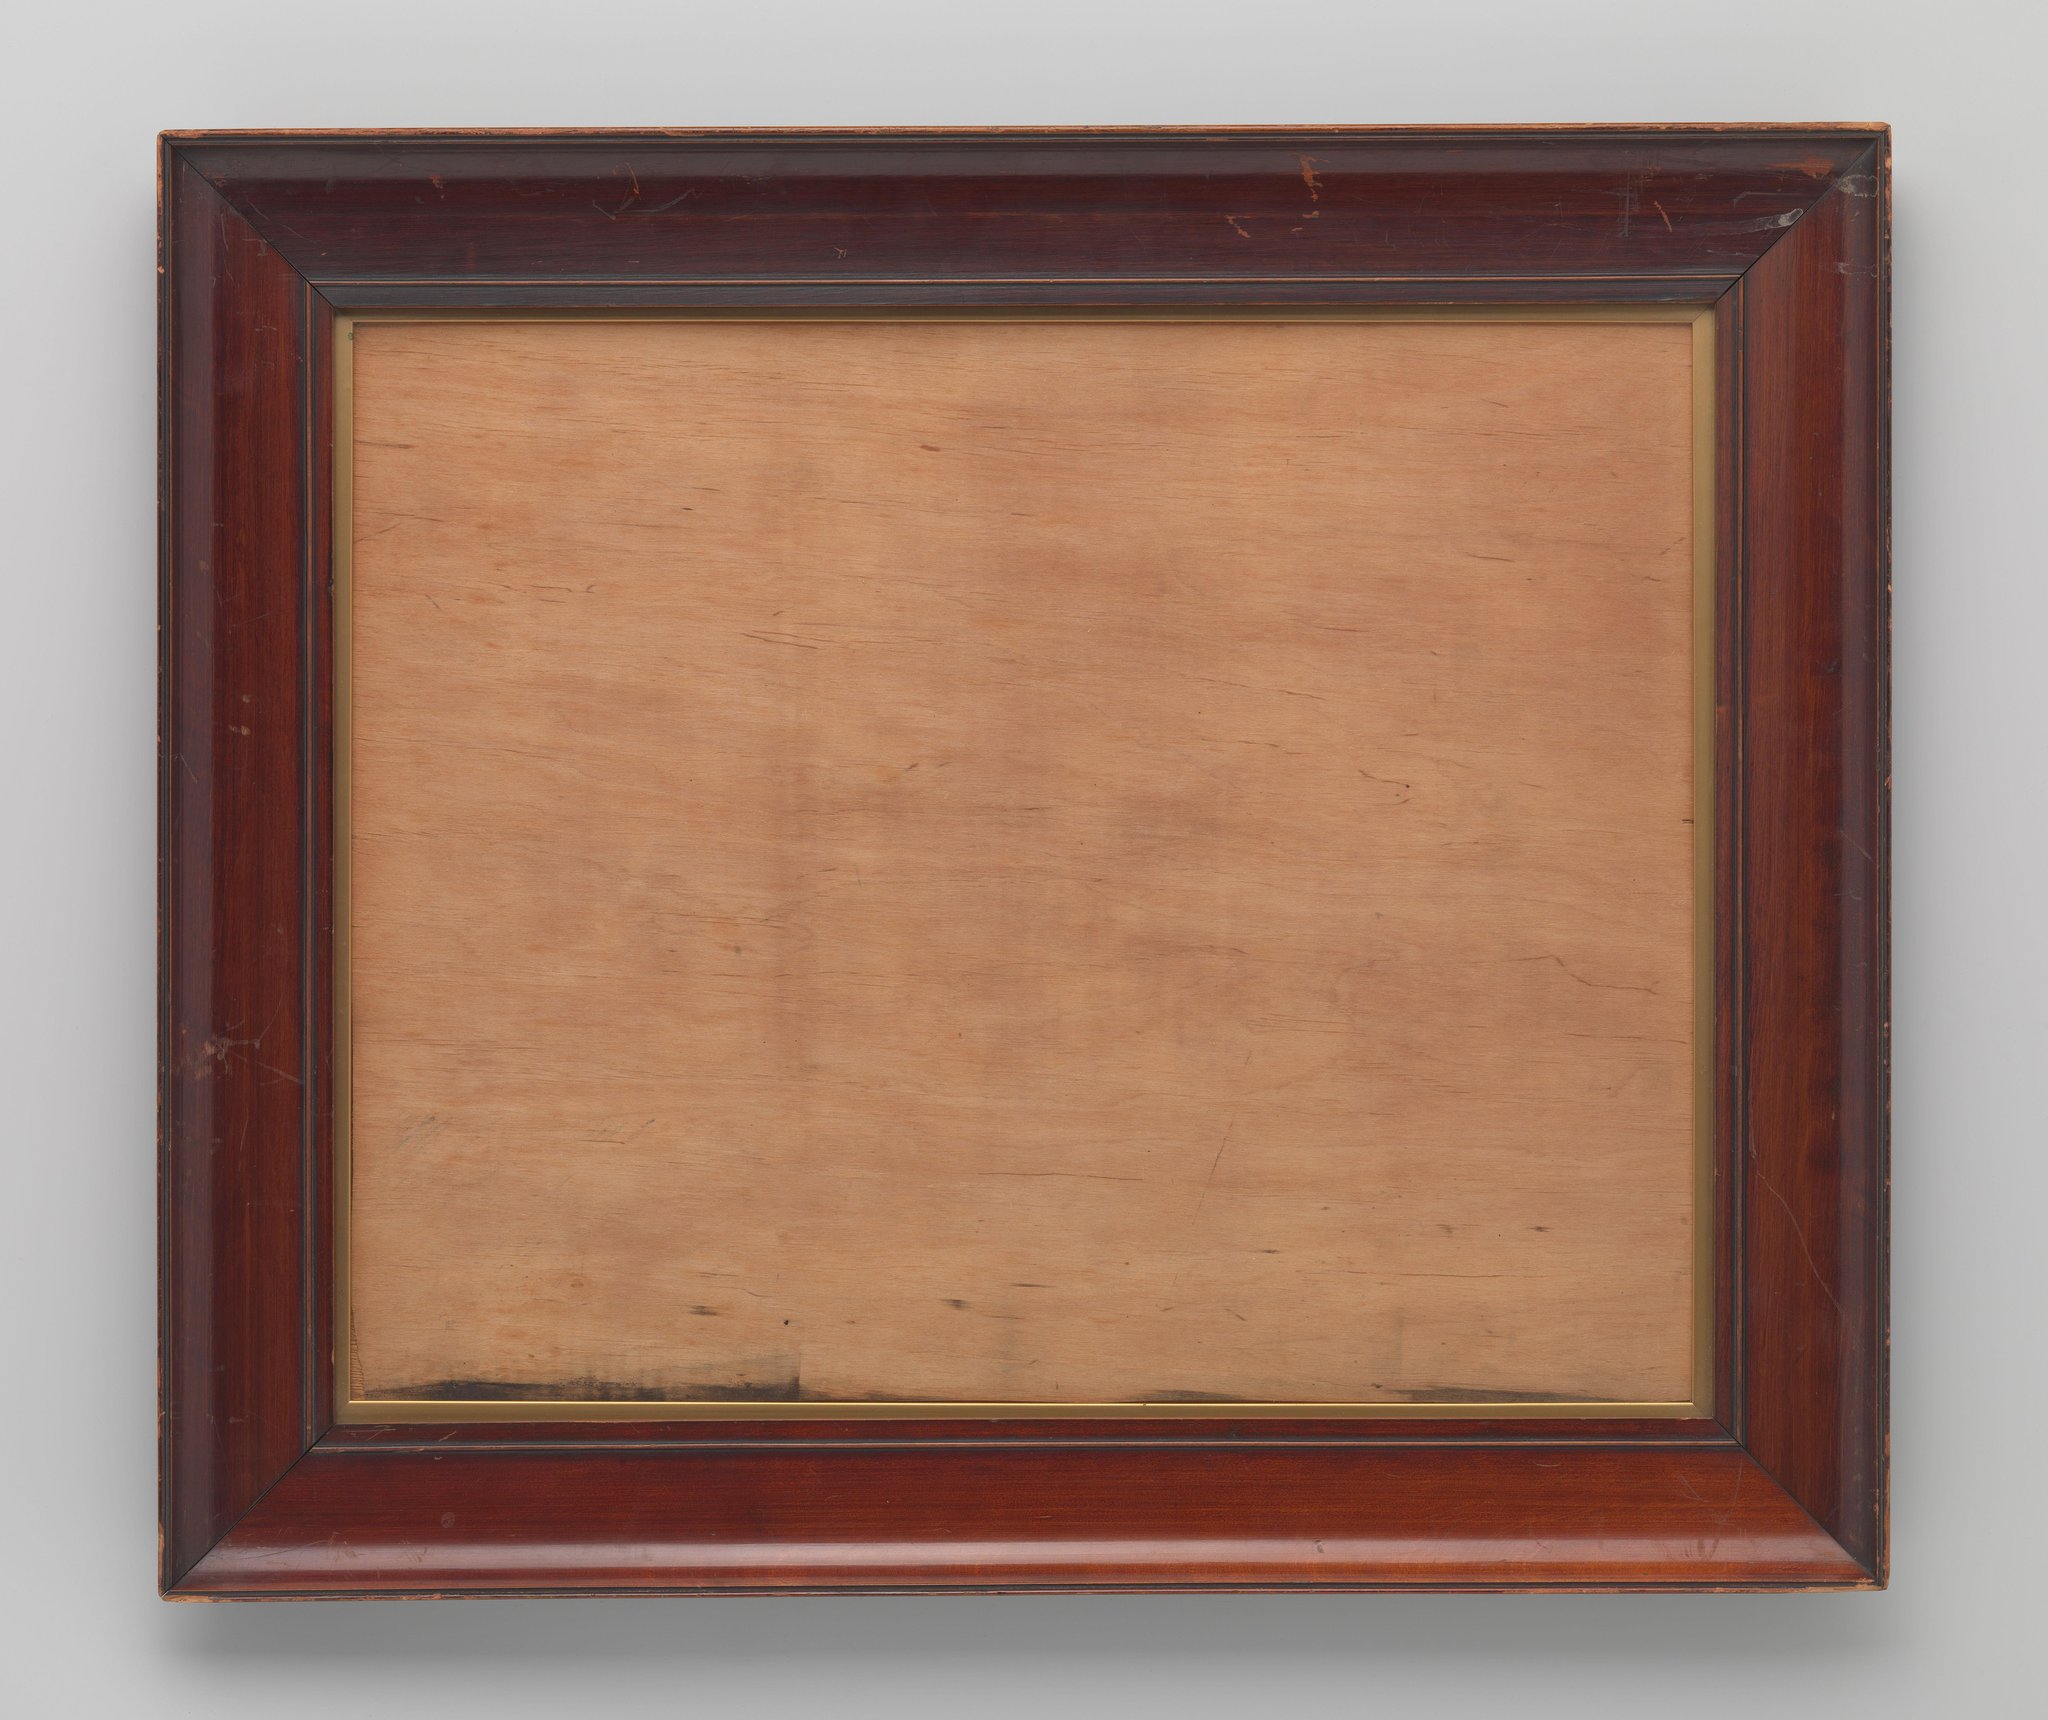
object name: frame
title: Picture Frame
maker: Anonymous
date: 1850-1919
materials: wood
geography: netherlands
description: Lijst behorende bij foto van Niagara Falls.